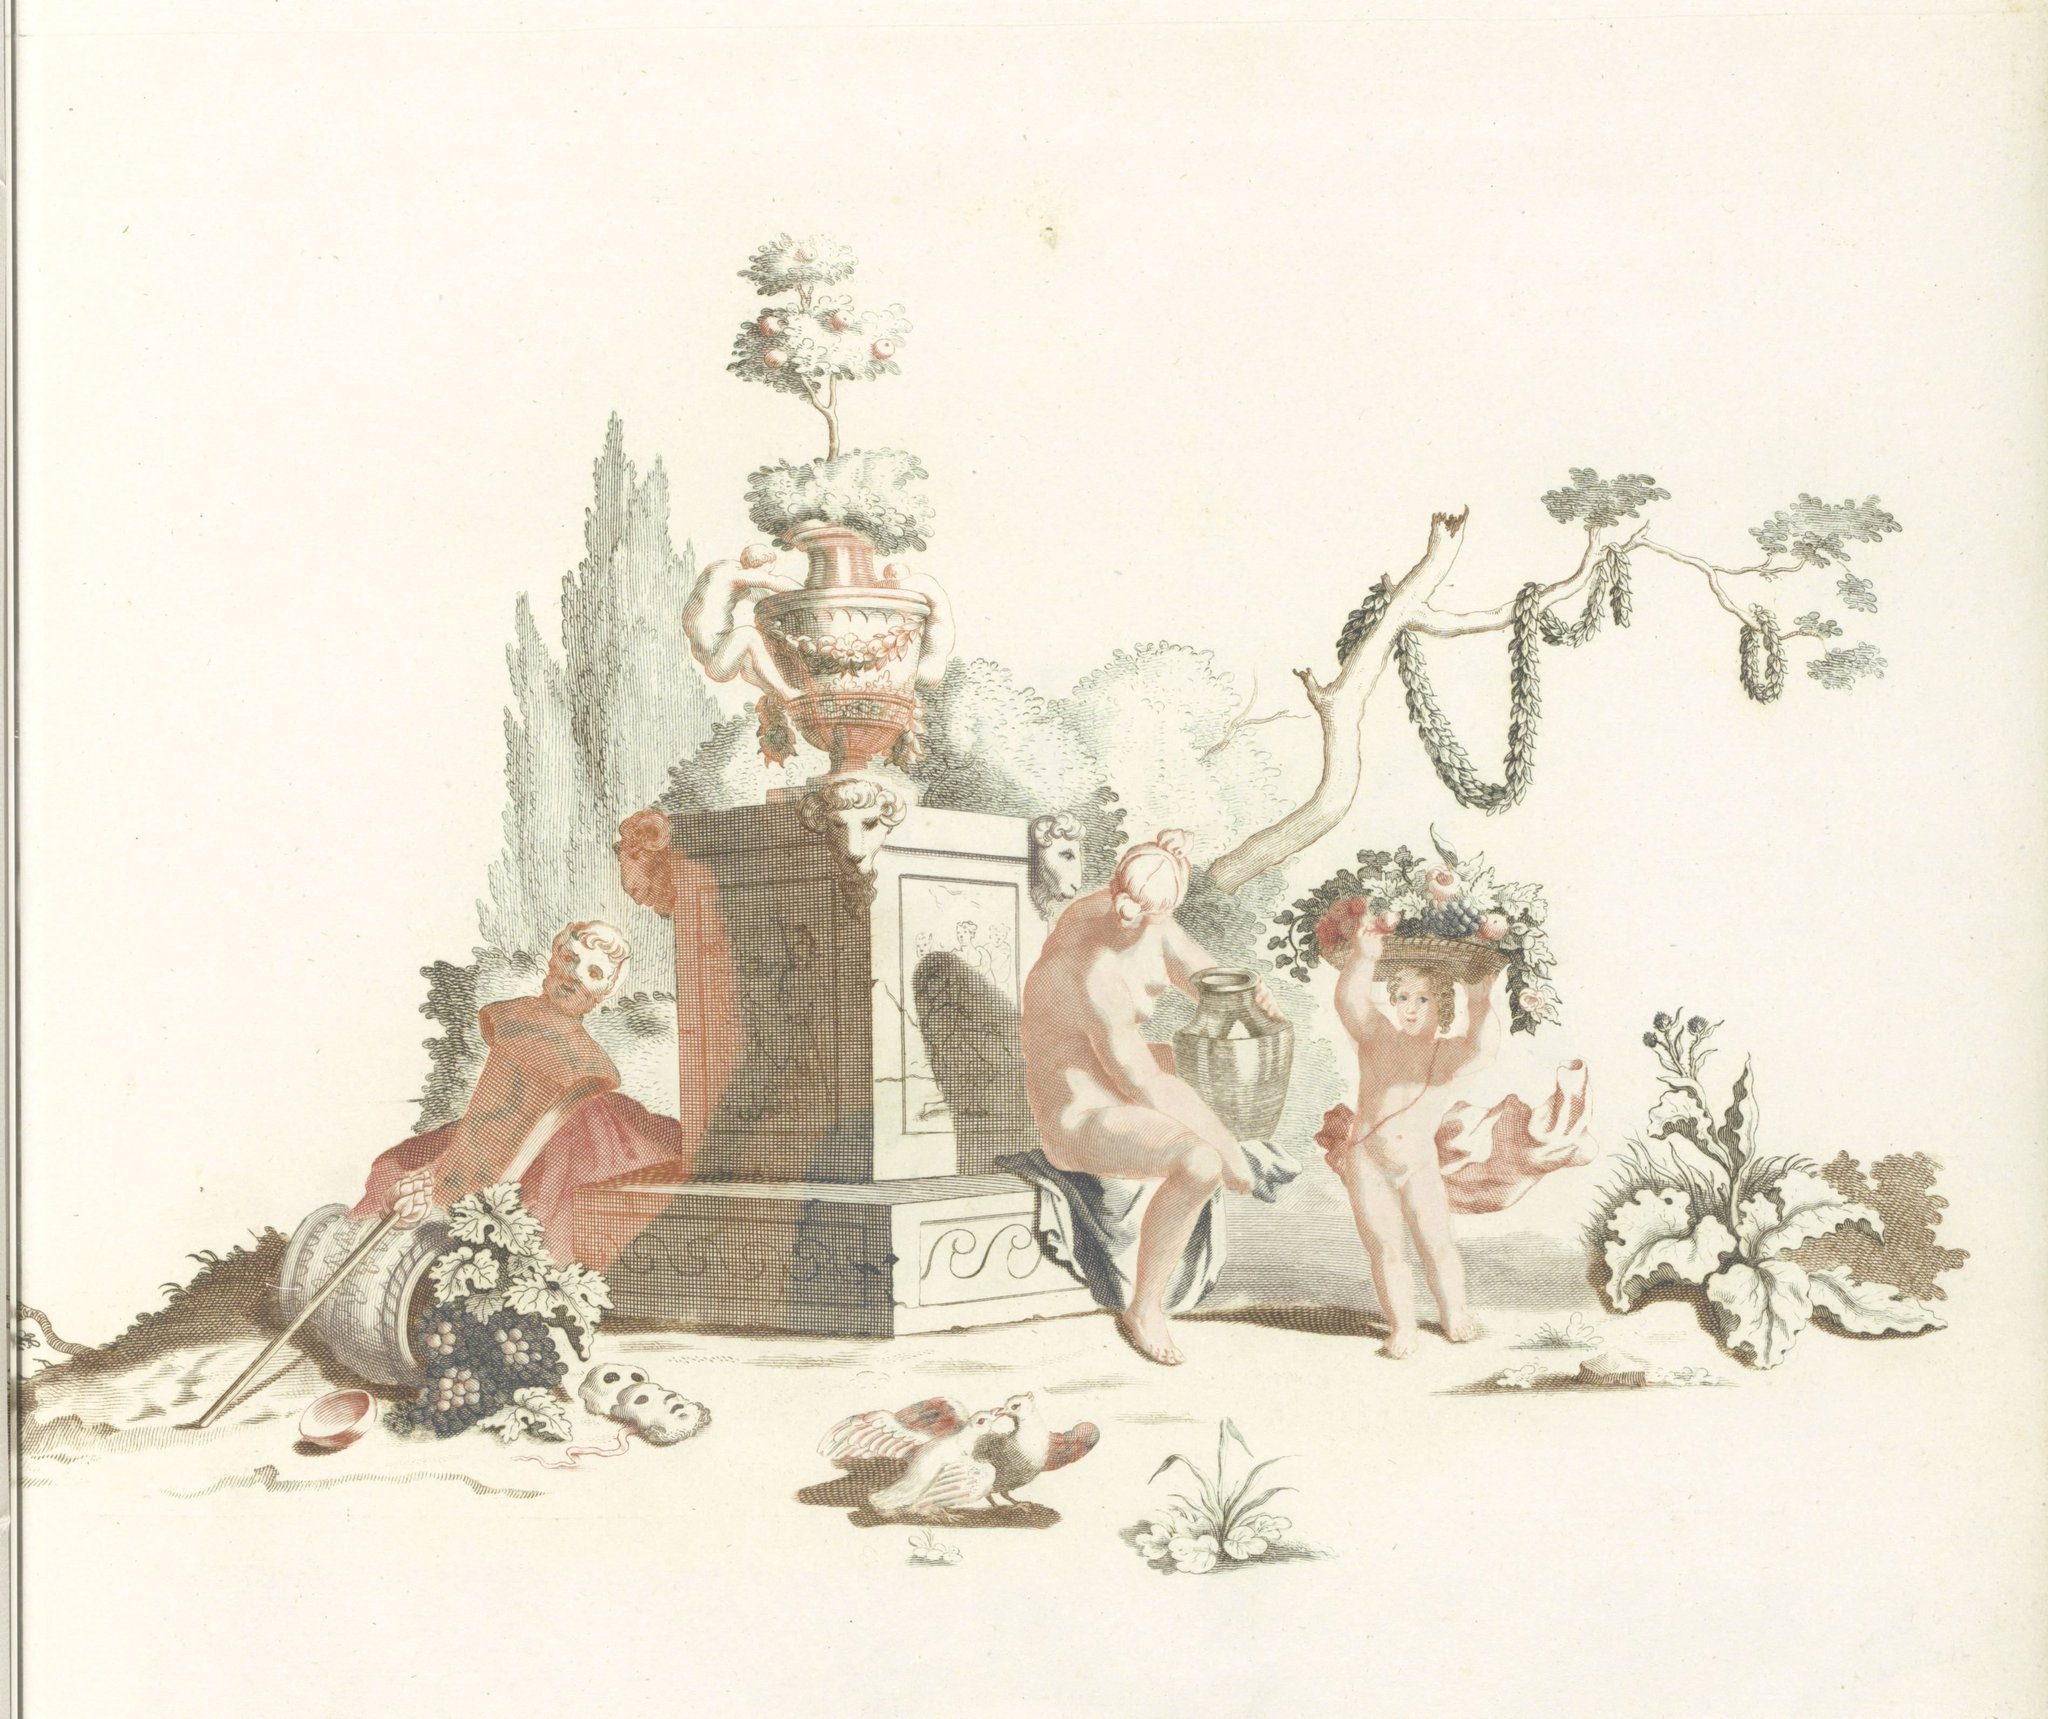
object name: print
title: Vrouw en een jongen met een bloemenmand boven zijn hoofd aan de voet van een monument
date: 1688-1698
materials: paper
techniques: printing, engraving, hand coloring, lithography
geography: netherlands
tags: monument, statue, carrying something on the head or on the shoulders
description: Een naakte vrouw zit aan de voet van een monument of altaar. Naast haar staat een jongen of putto met een bloemenmand op het hoofd. Links een omgevallen vat met druiven, een thyrsus en maskers. Op de voorgrond een koppel duiven. Deze prent maakt deel uit van een album.